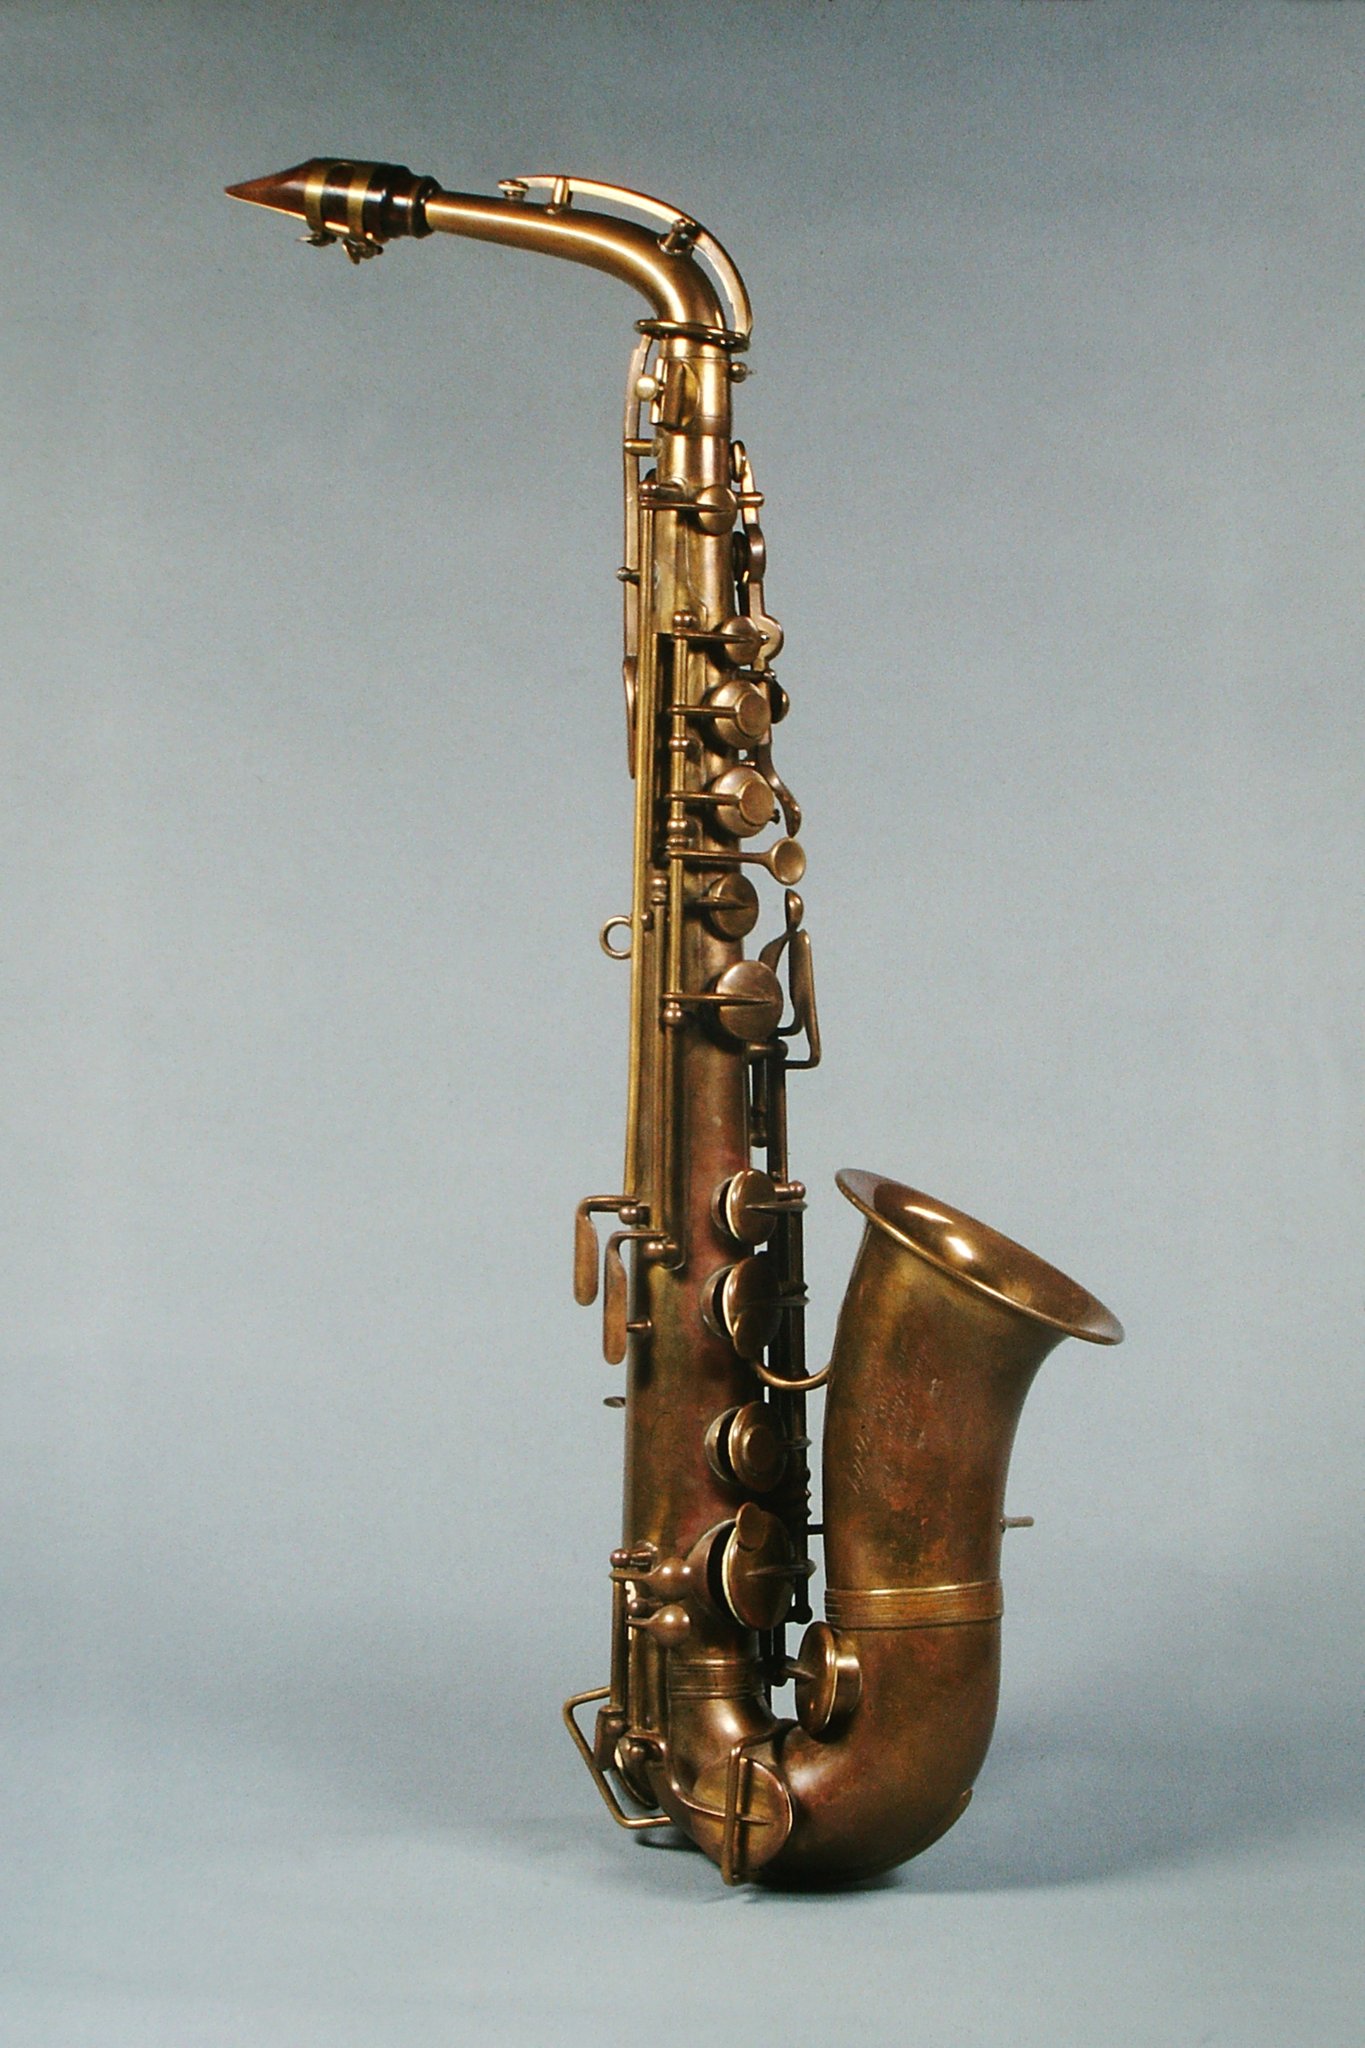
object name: alto saxophone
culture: french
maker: arsene-zoe lecomte & cie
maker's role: maker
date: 1887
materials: brass, wood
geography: france